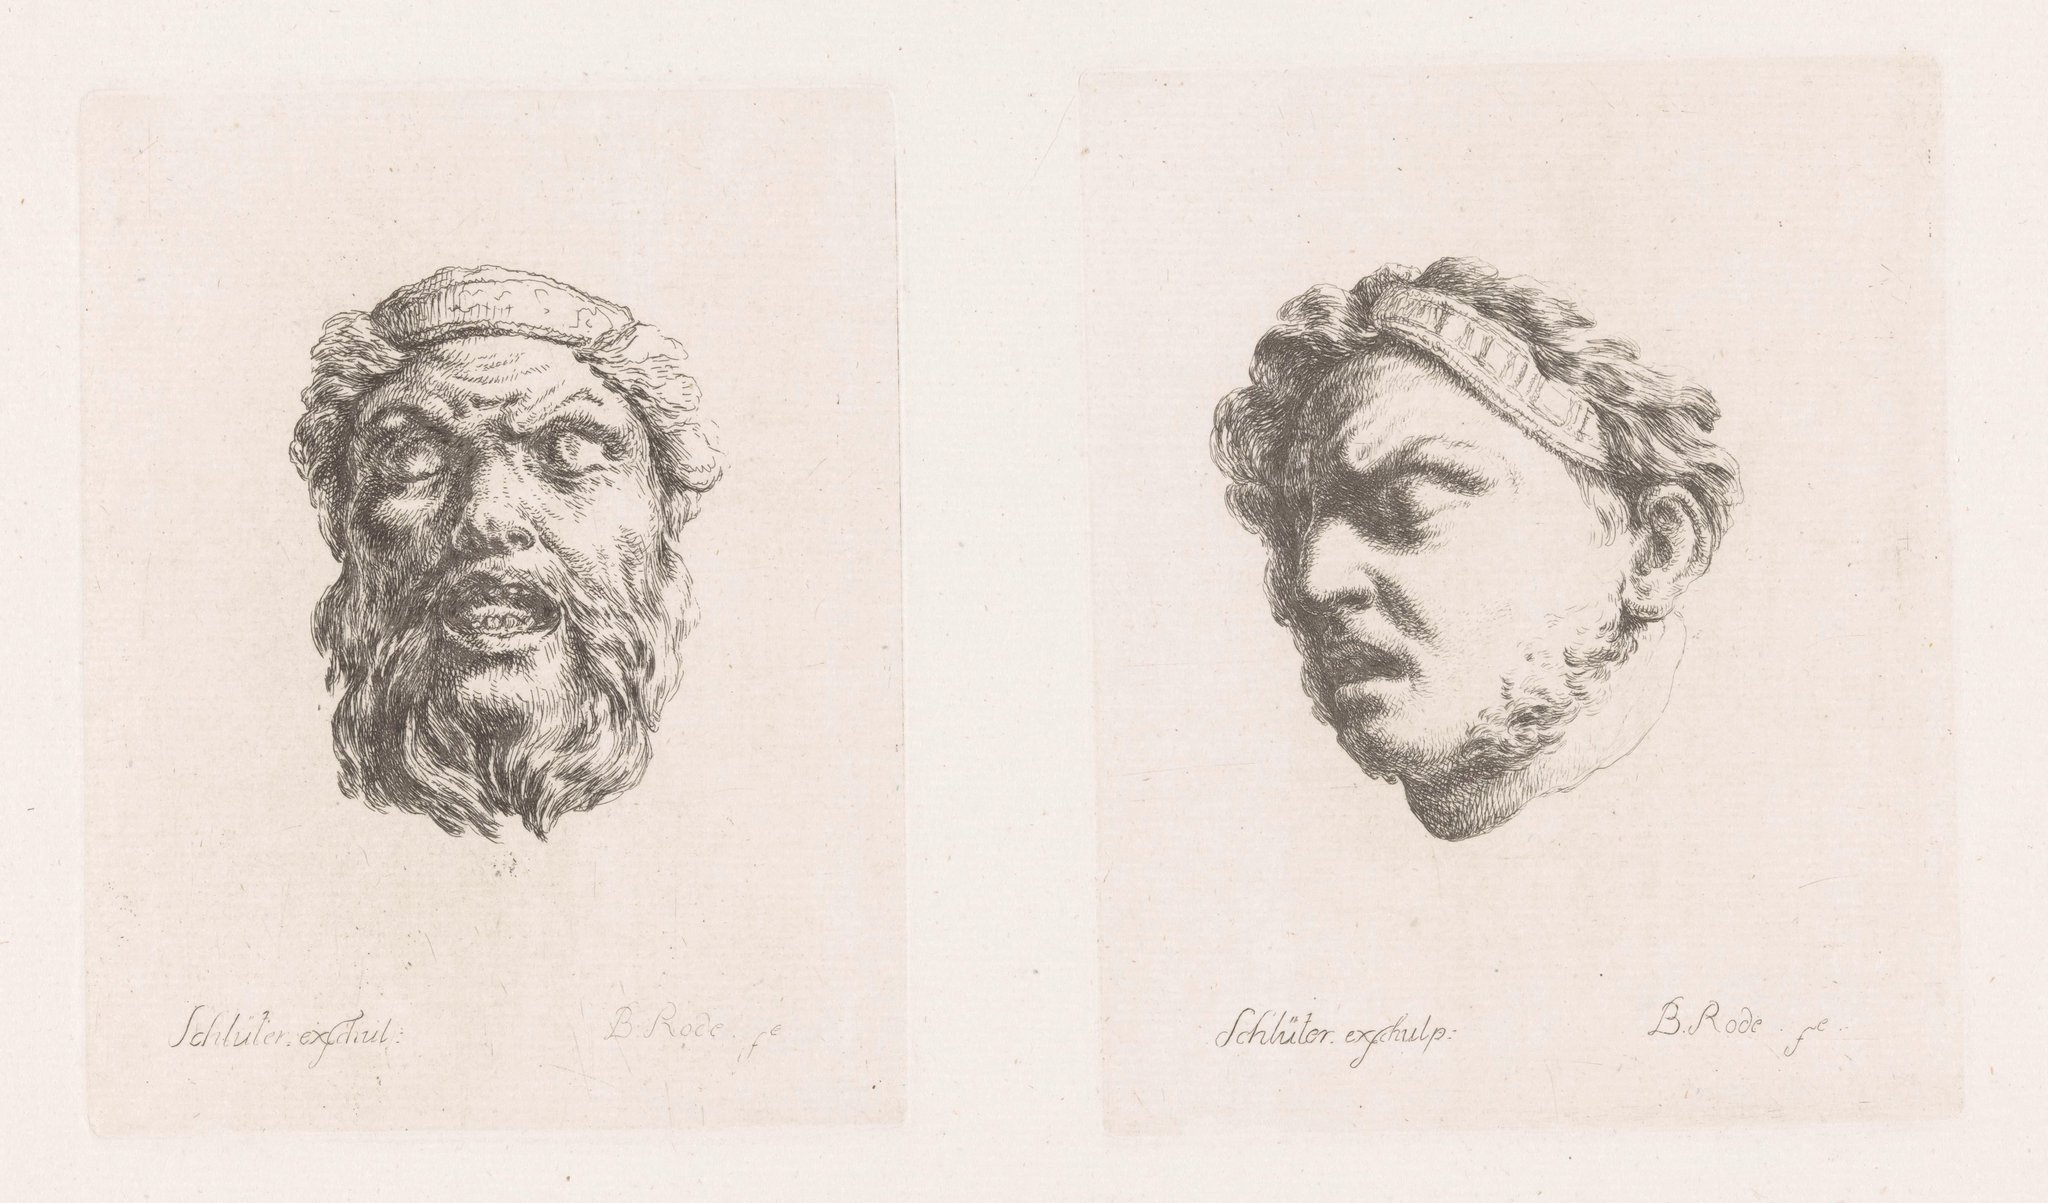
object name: ornament print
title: Twee gestorven krijgers met haarband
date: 1759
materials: paper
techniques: etching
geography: berlin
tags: mask, mascaron ~ ornament, the soldier; the soldier's life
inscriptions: collector's mark: Lugt 2228, collector's mark: Lugt 2760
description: Prent is gemaakt naar de sculpturen van Andreas Schlüter in het Zeughaus (tegenwoordig het Deutsches Historisches Museum) te Berlijn. Mogelijk prent uit: Rode, Bernhard. Larven nach den Modelen des berühmten Schlüters gezeichnet und in Kupfer geätzt von B. Rode. Berlijn: Rode, Heinrich, 1759.